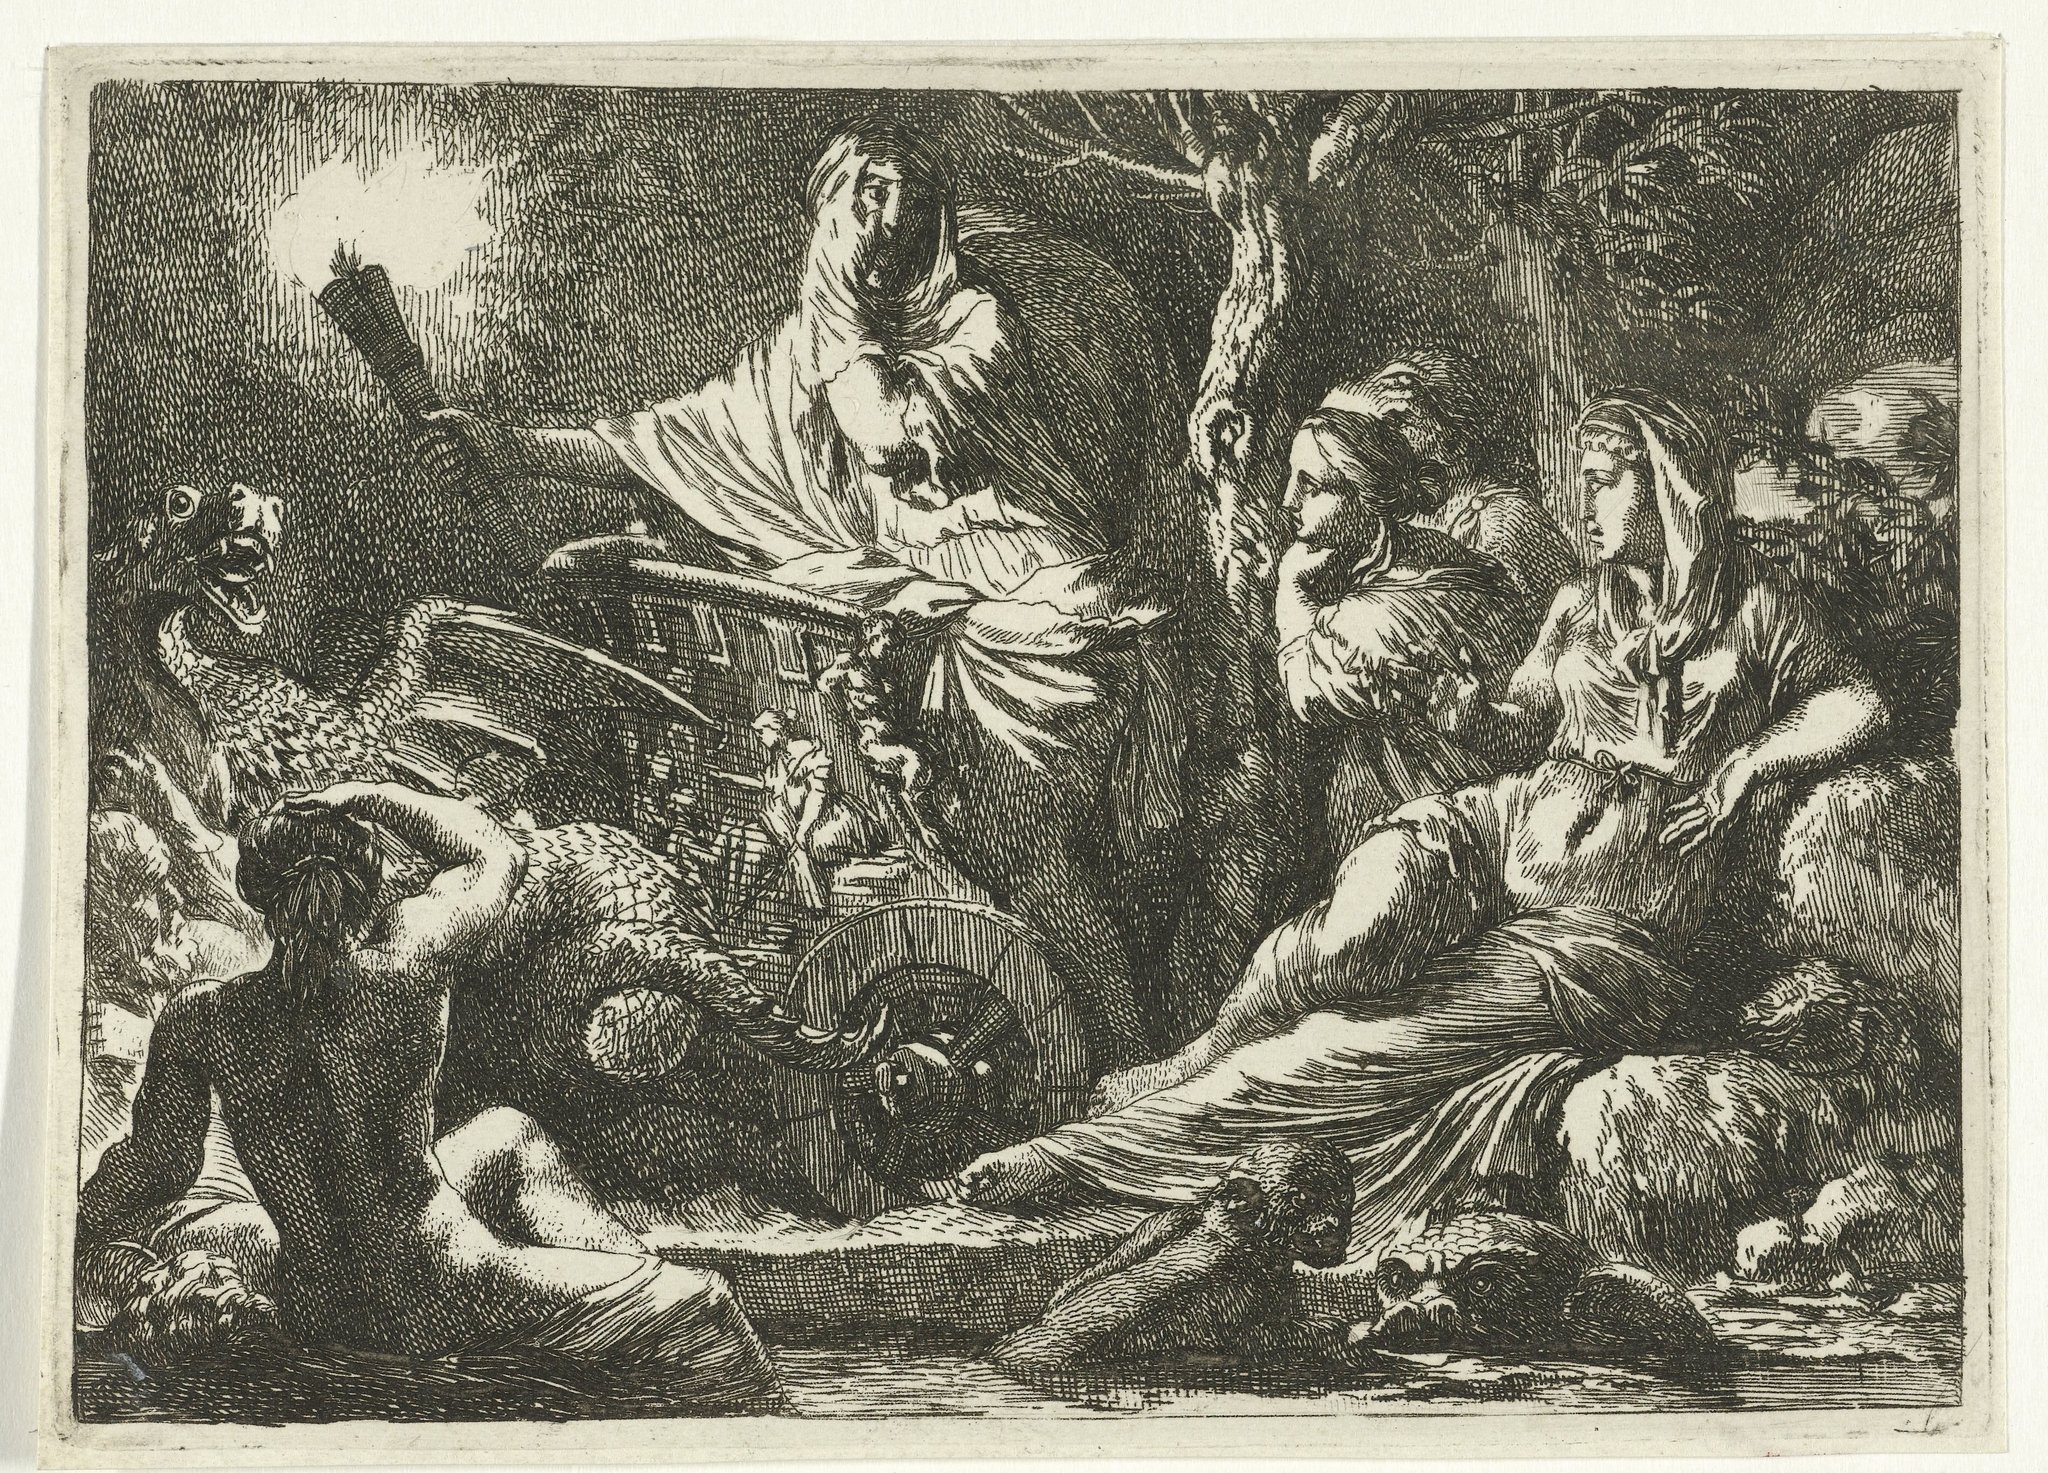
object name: print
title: Ceres op zoek naar Proserpina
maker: gerard de lairesse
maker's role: draughtsman, painter, print maker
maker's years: 1641-1711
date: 1670-1675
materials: paper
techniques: etching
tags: most important deeds: ceres in search of her daughter proserpina, whom pluto carried off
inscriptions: collector's mark: Lugt 240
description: Ceres, godin van de landbouw, rijdt gesluierd met een toorts in haar hand op een door draken getrokken wagen. Ze is op zoek naar haar dochter Proserpina die door Pluto geroofd is. Op de voorgrond zitten vrouwen bij een beek waarin monsterachtige wezens zwemmen. Scène uit de Metamorfosen van Ovidius.